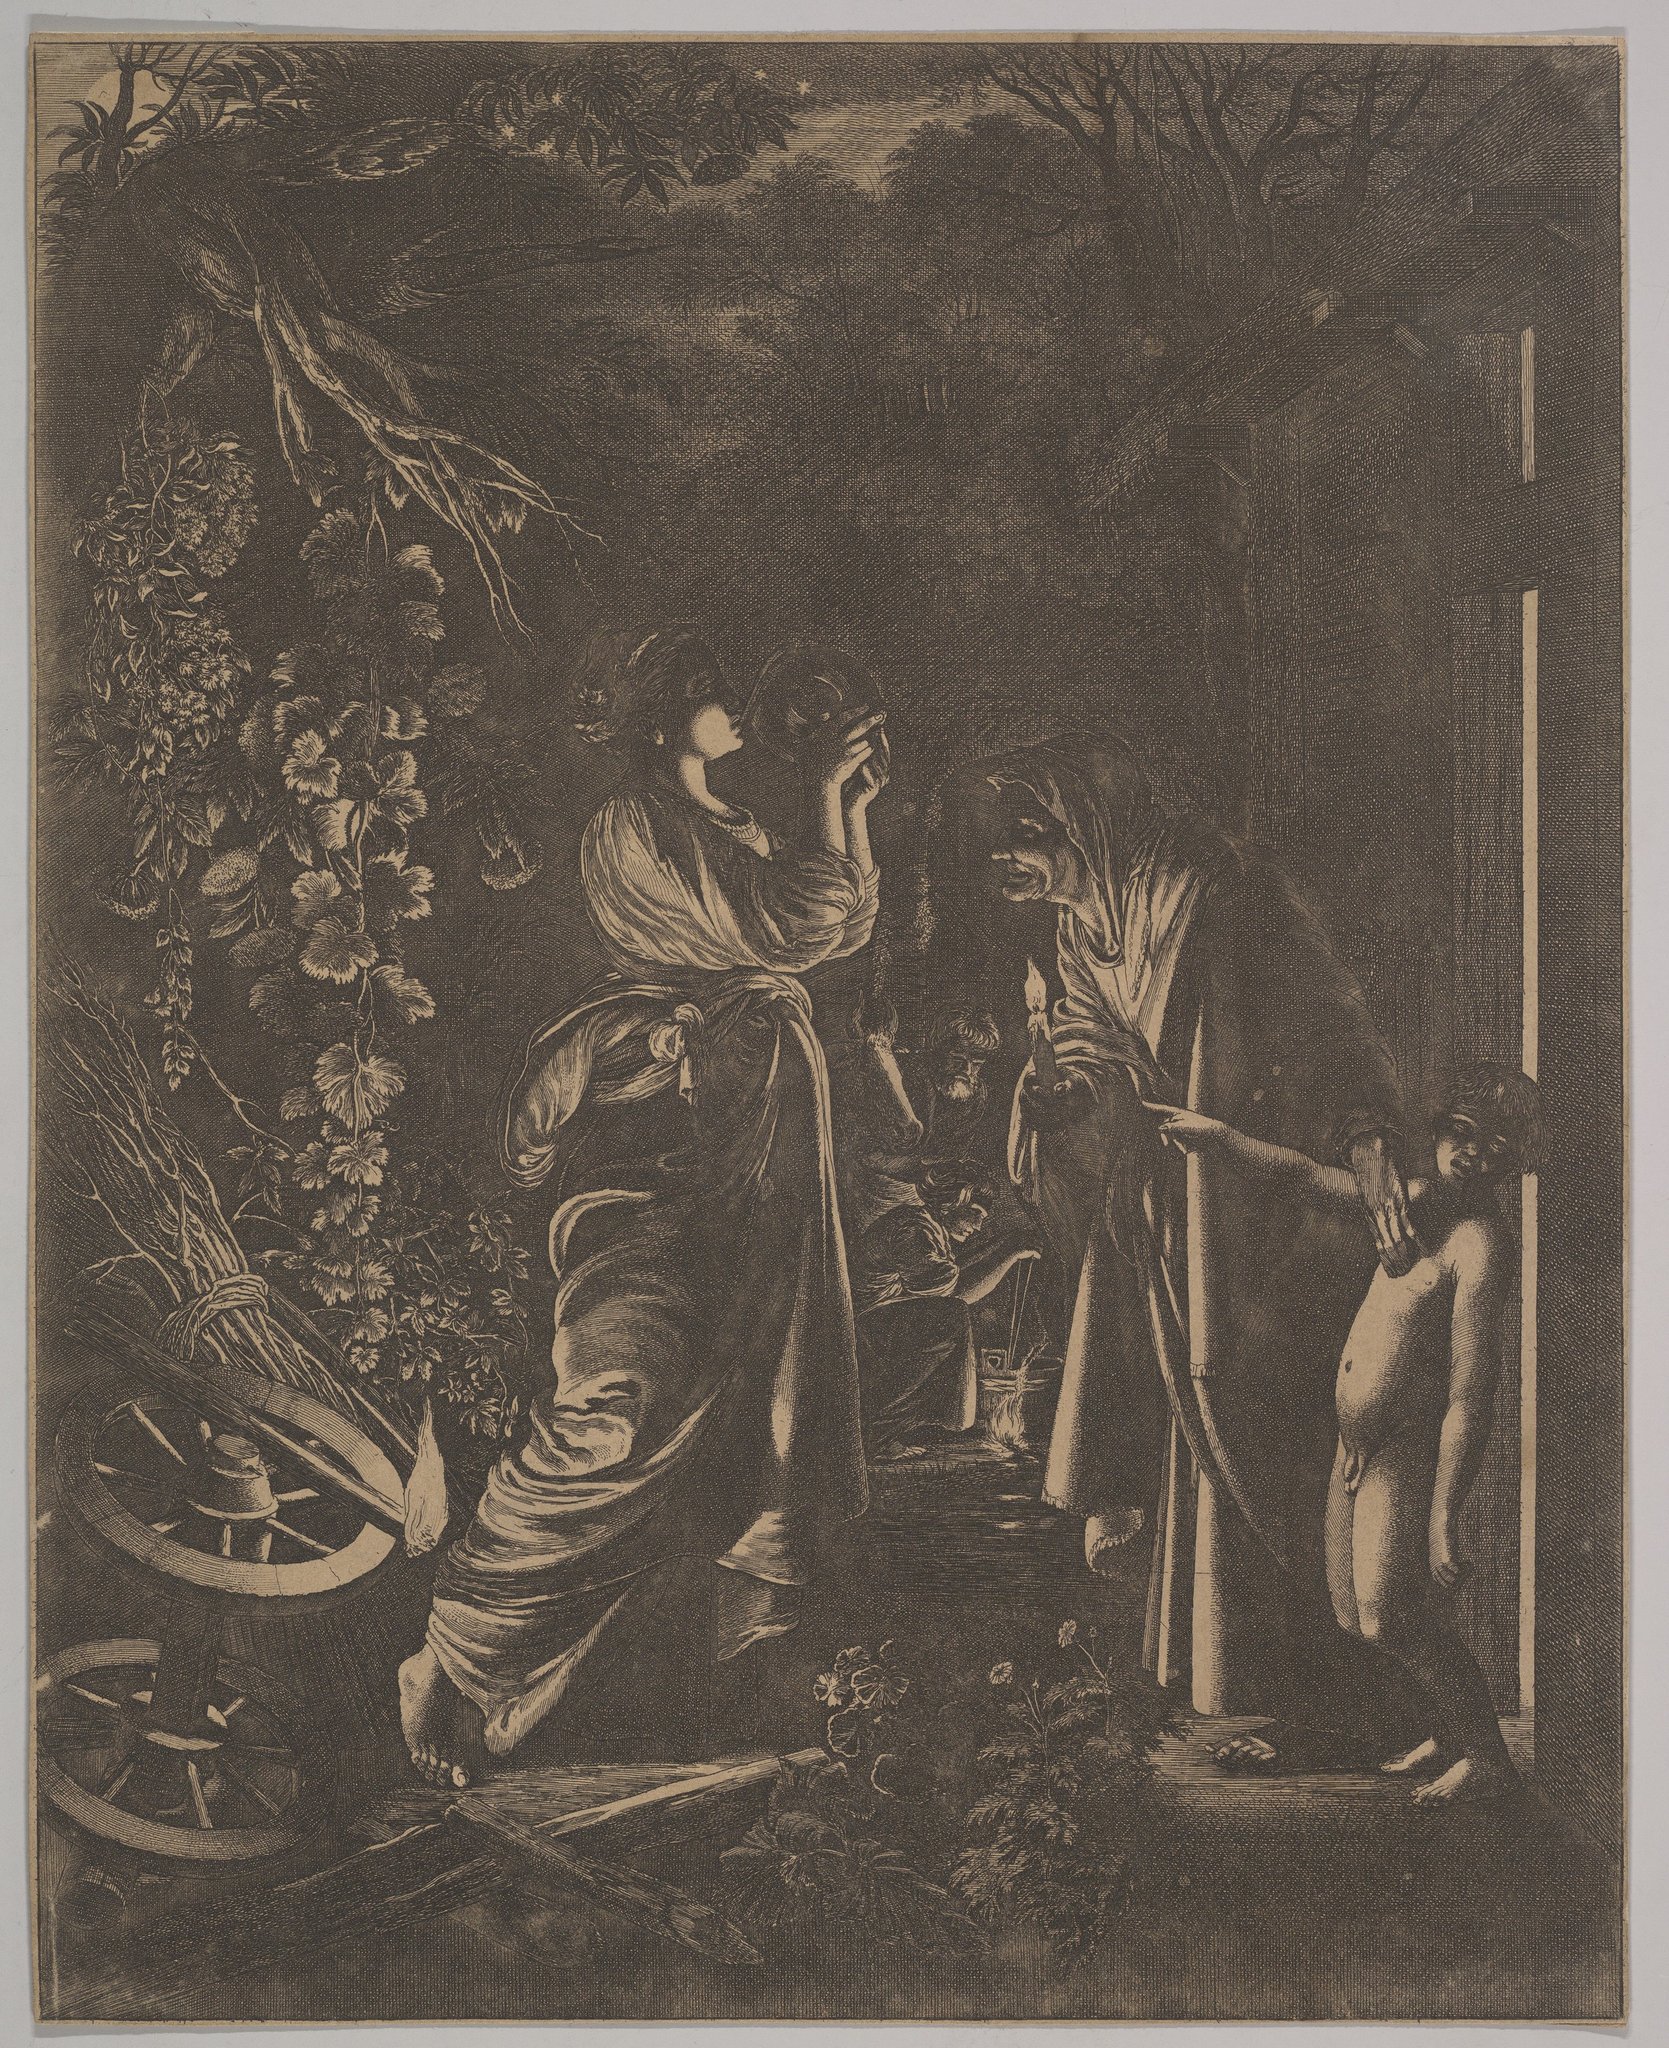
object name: print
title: Ceres Seeking Her Daughter or Ceres and Stillio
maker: wenceslaus hollar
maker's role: artist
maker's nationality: bohemian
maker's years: 1607-1677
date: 1646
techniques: etching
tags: boys,women,ceres